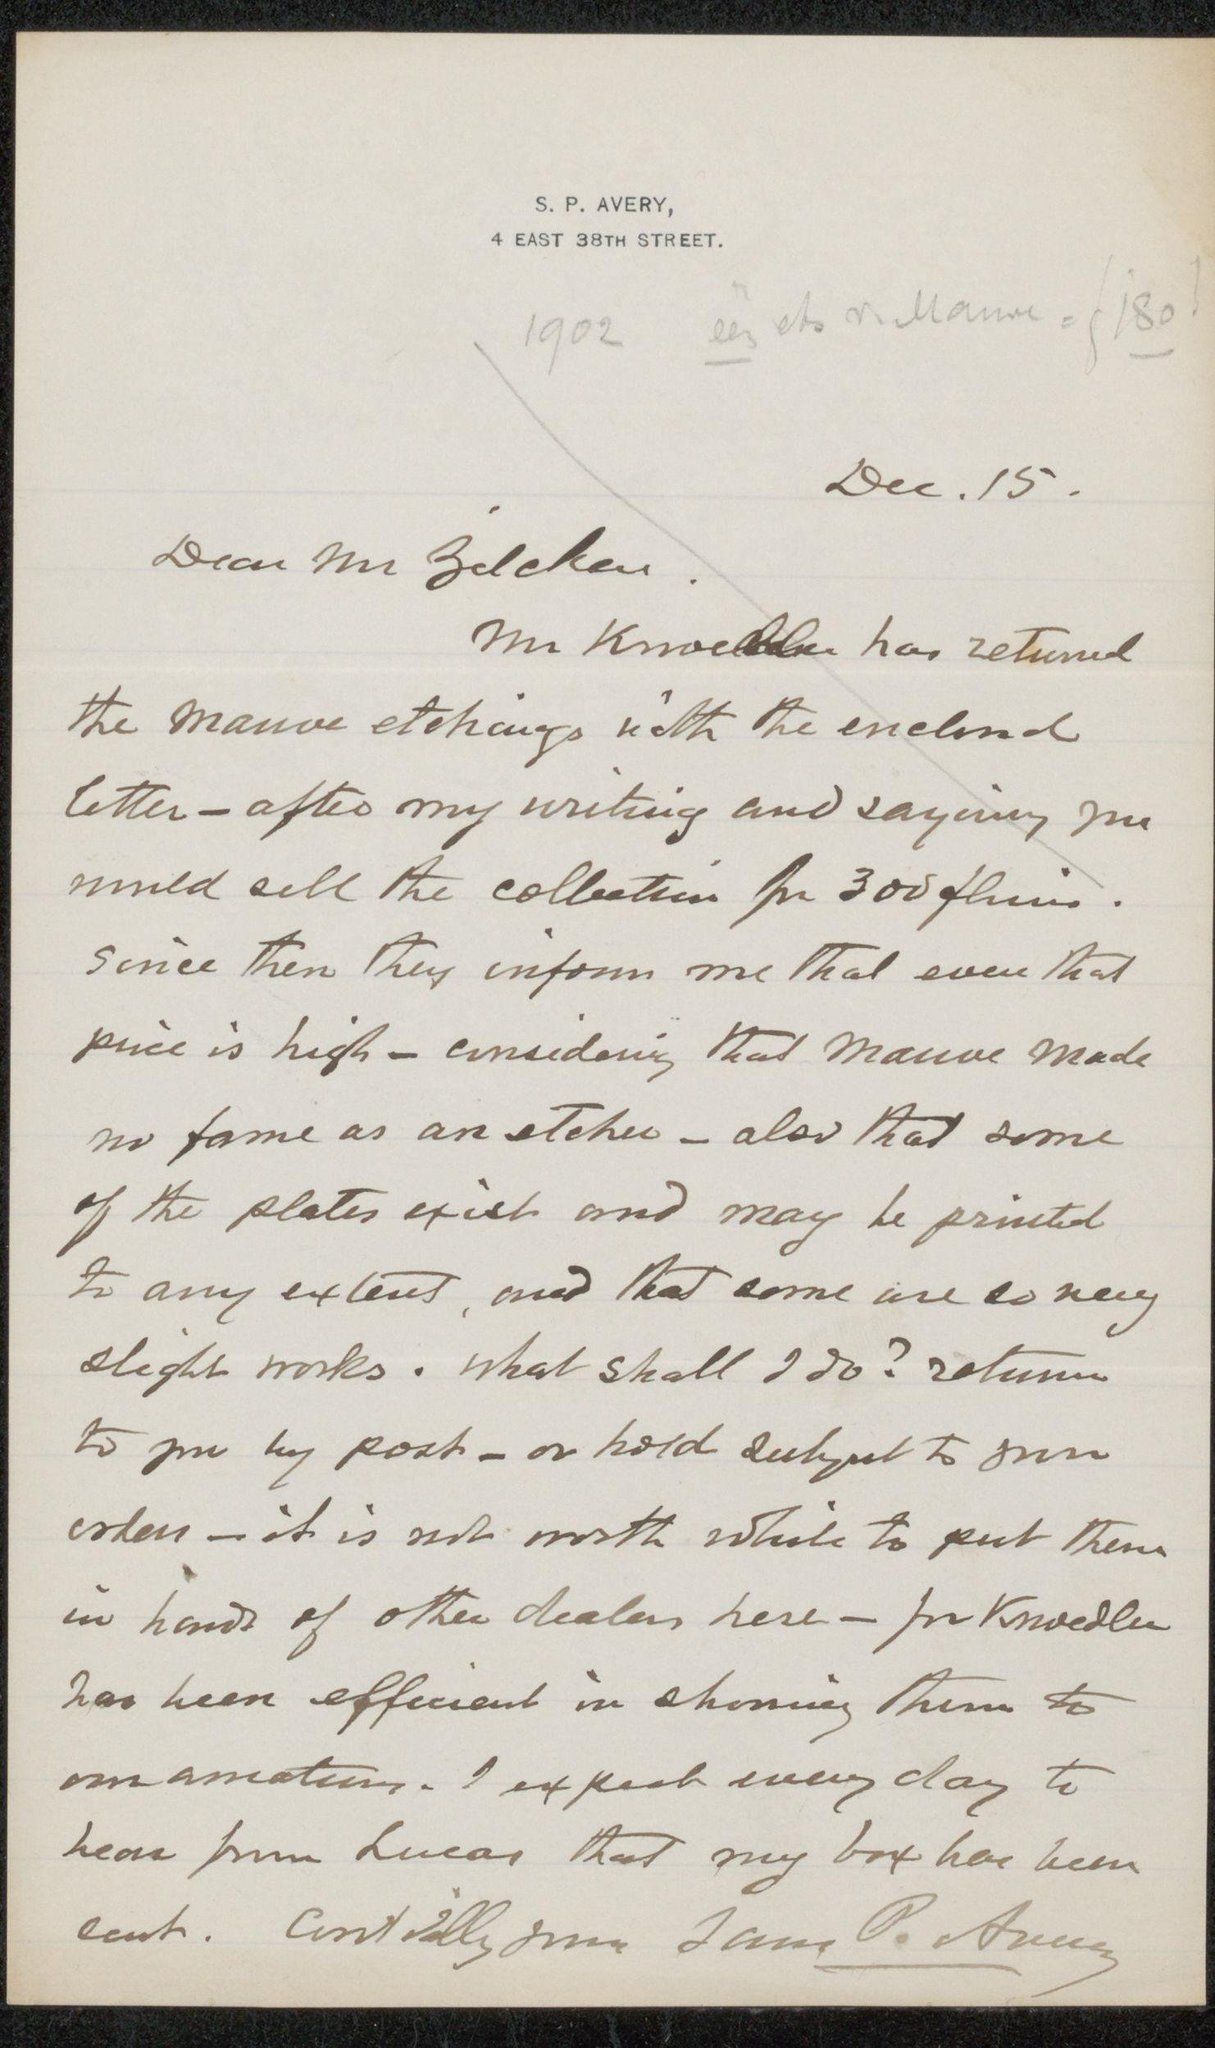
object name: letter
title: Brief aan Philip Zilcken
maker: samuel putnam avery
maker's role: verzamelaar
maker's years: 1822-1904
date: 1832-1904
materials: ink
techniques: pen, printing, writing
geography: new york city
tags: arnhem, print maker, anton mauve, the hague, draughtsman, philip zilcken, the graphic arts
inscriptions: collector's mark: ‘RPK’